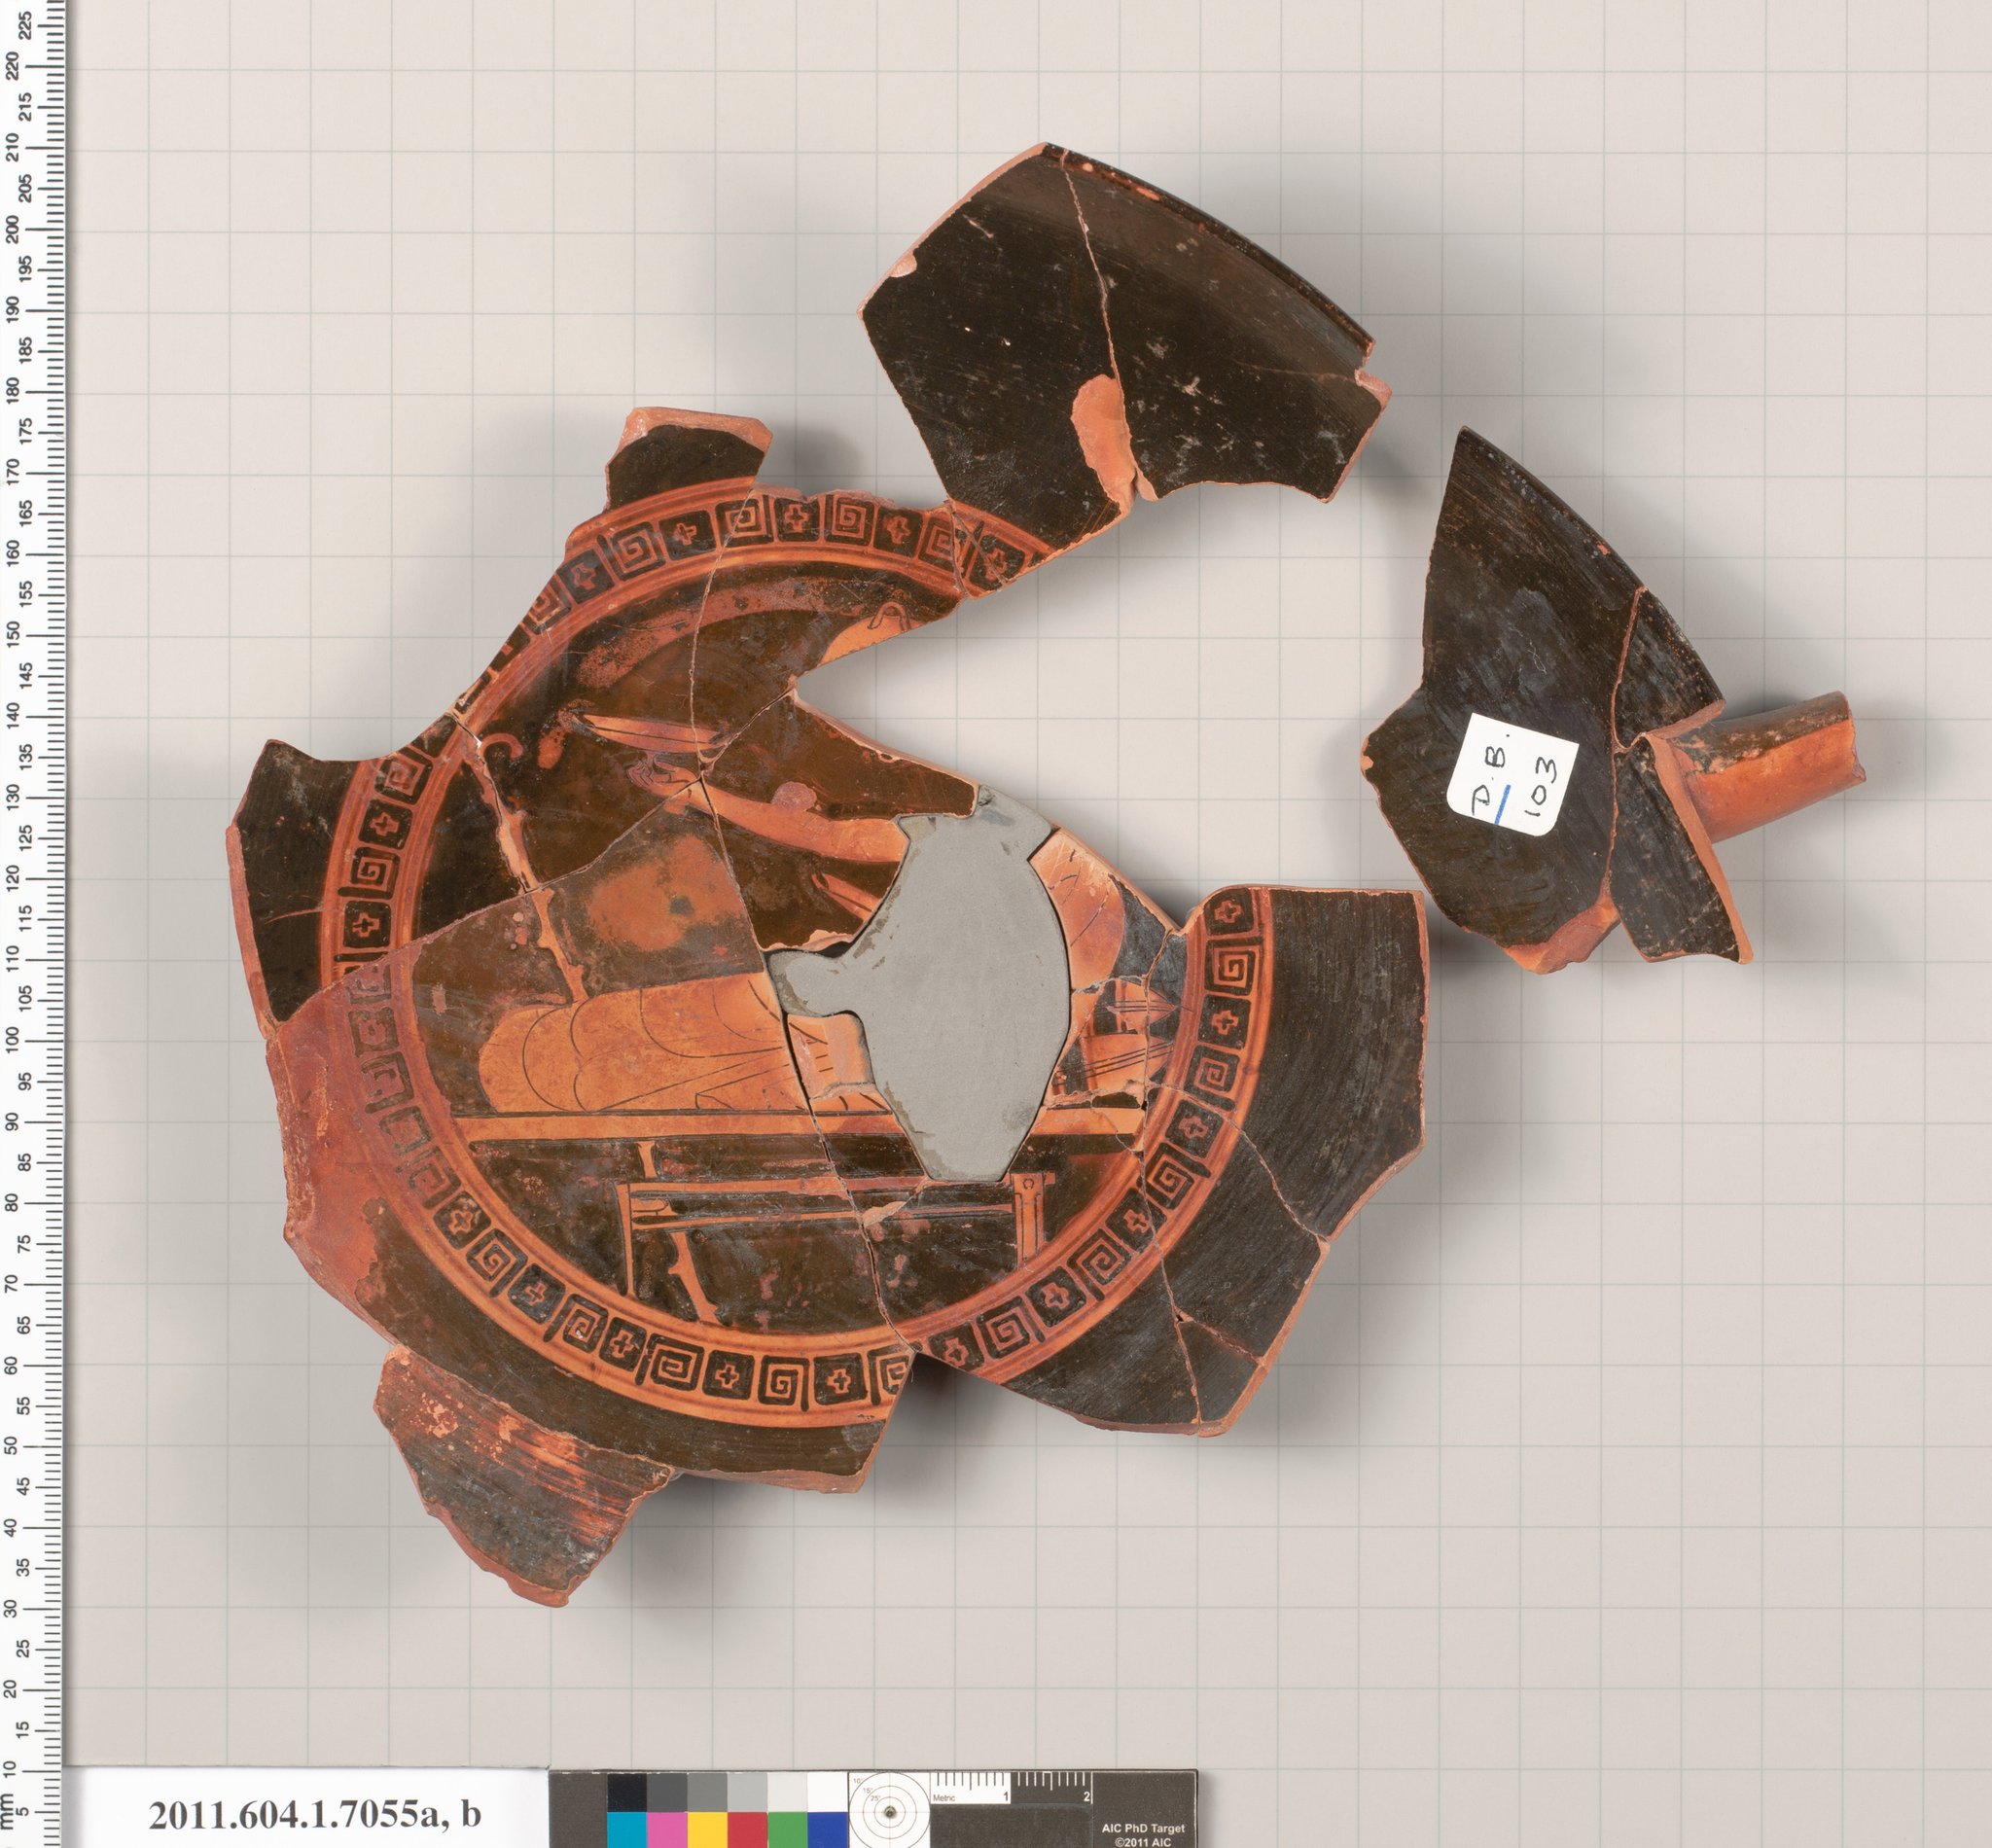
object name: kylix fragment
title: Terracotta fragments of a kylix (drinking cup)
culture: greek, attic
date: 500-480 BCE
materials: terracotta